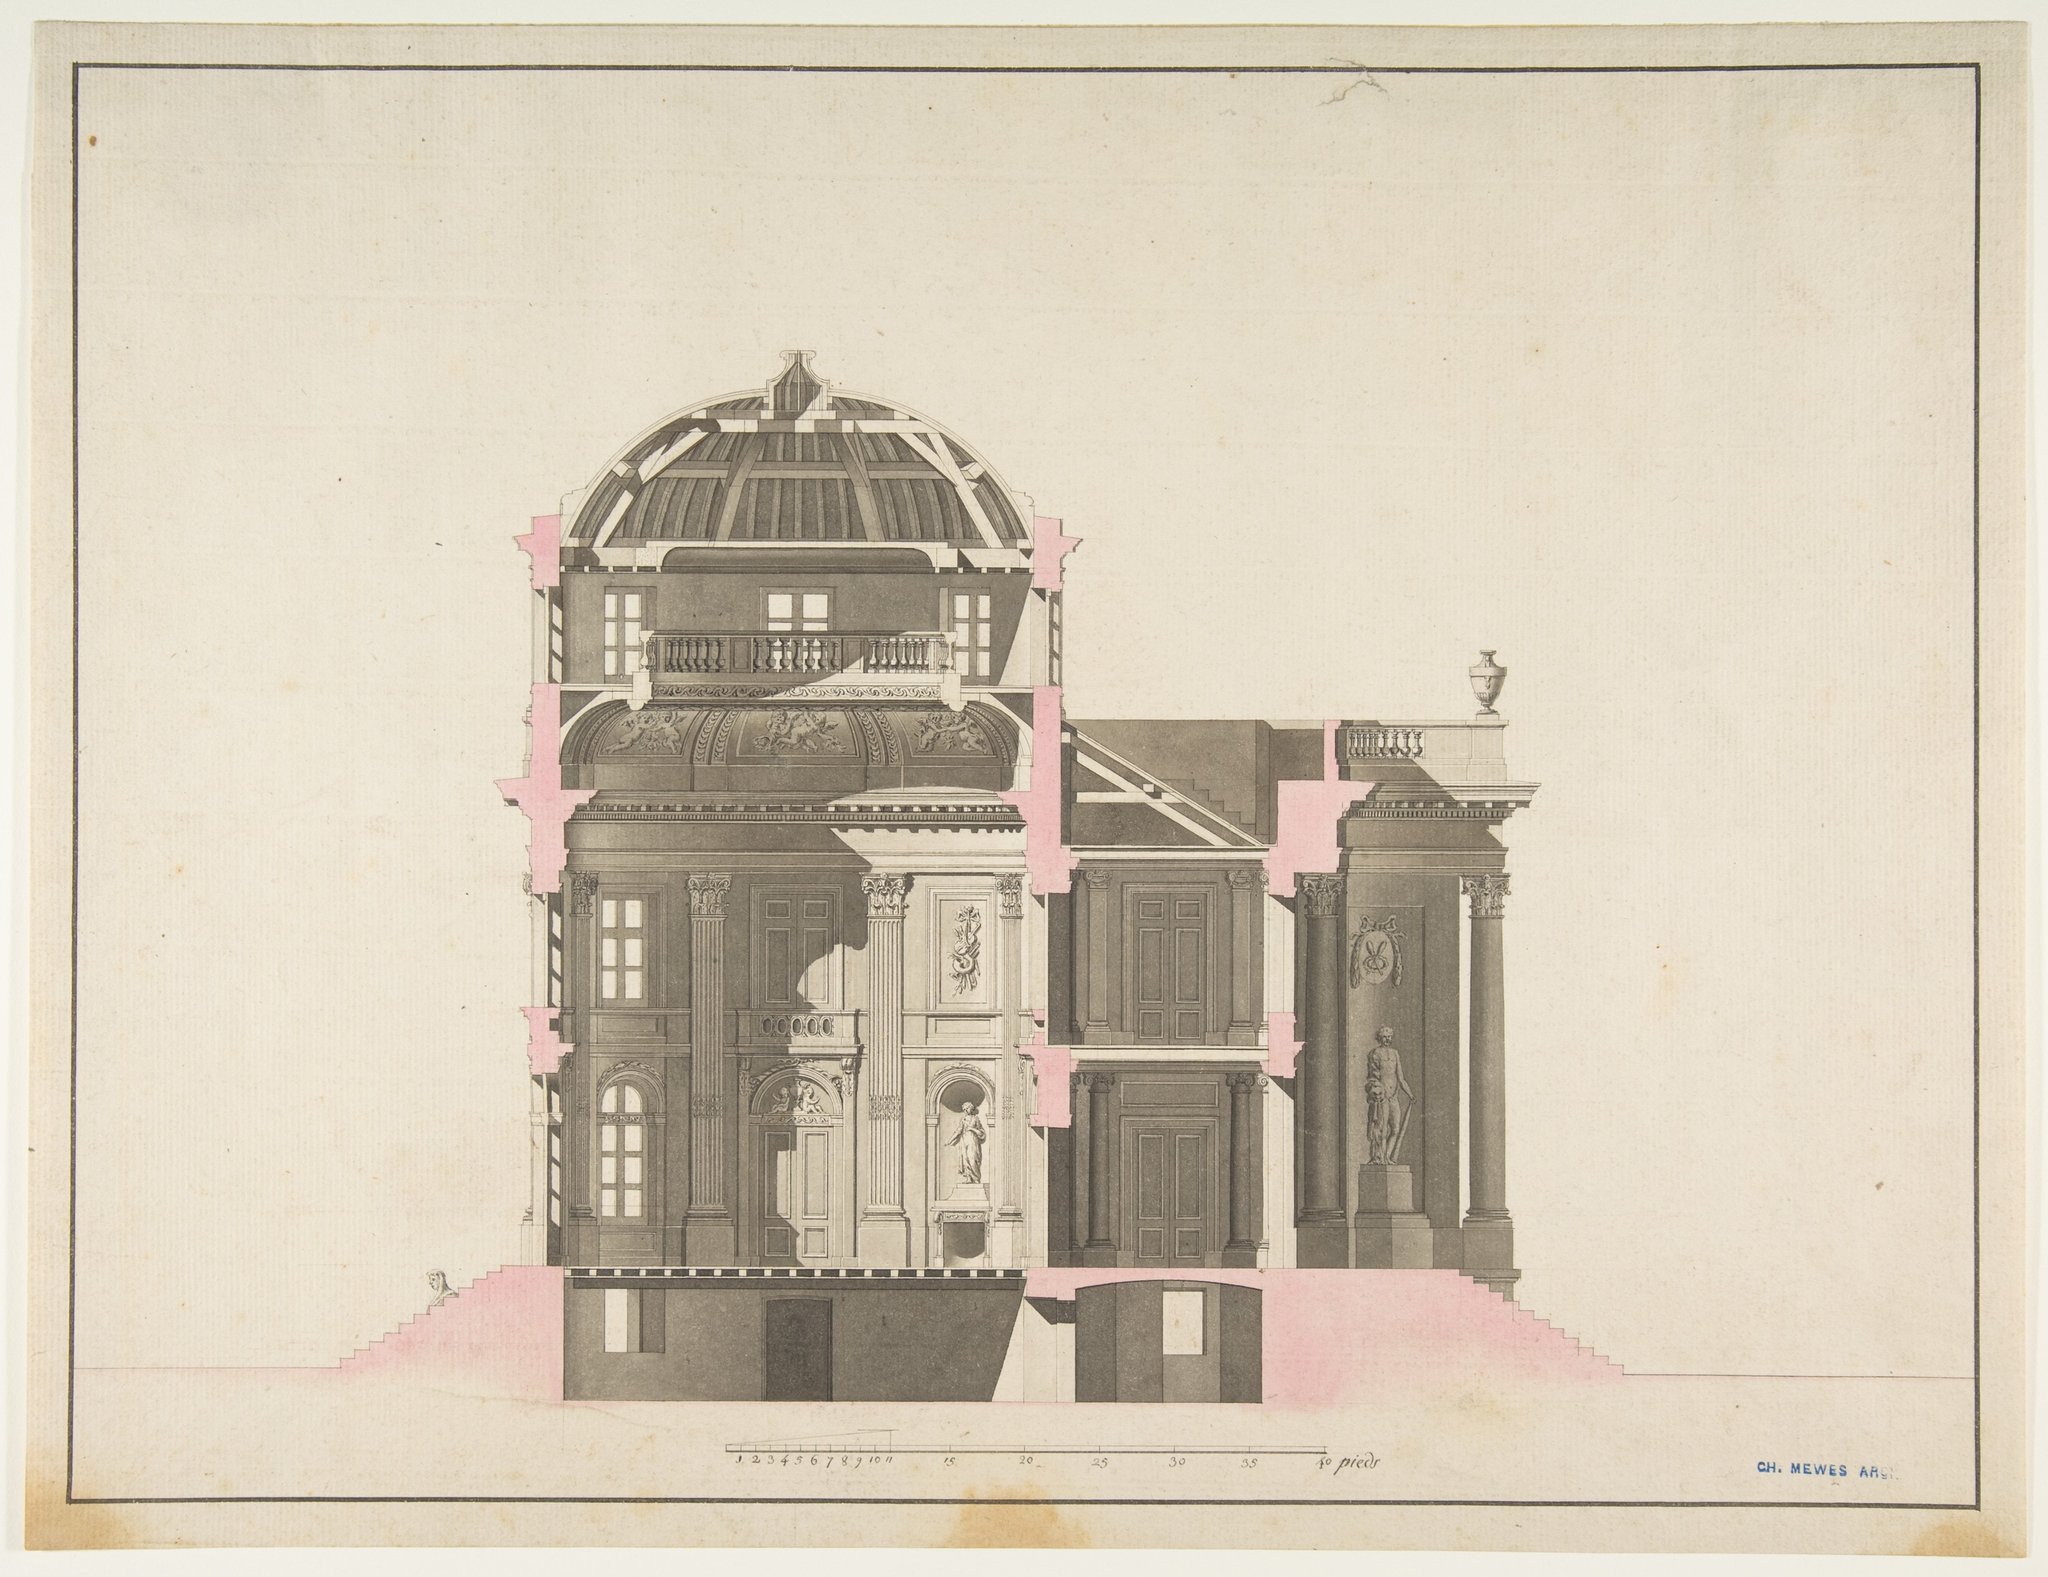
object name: drawing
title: Project for a Domed Building with Colonnaded Façade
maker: anonymous, french, 18th century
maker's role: artist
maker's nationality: french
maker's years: 1700-1800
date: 1701-1800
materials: ink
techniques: brush, pen, wash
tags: architecture,buildings